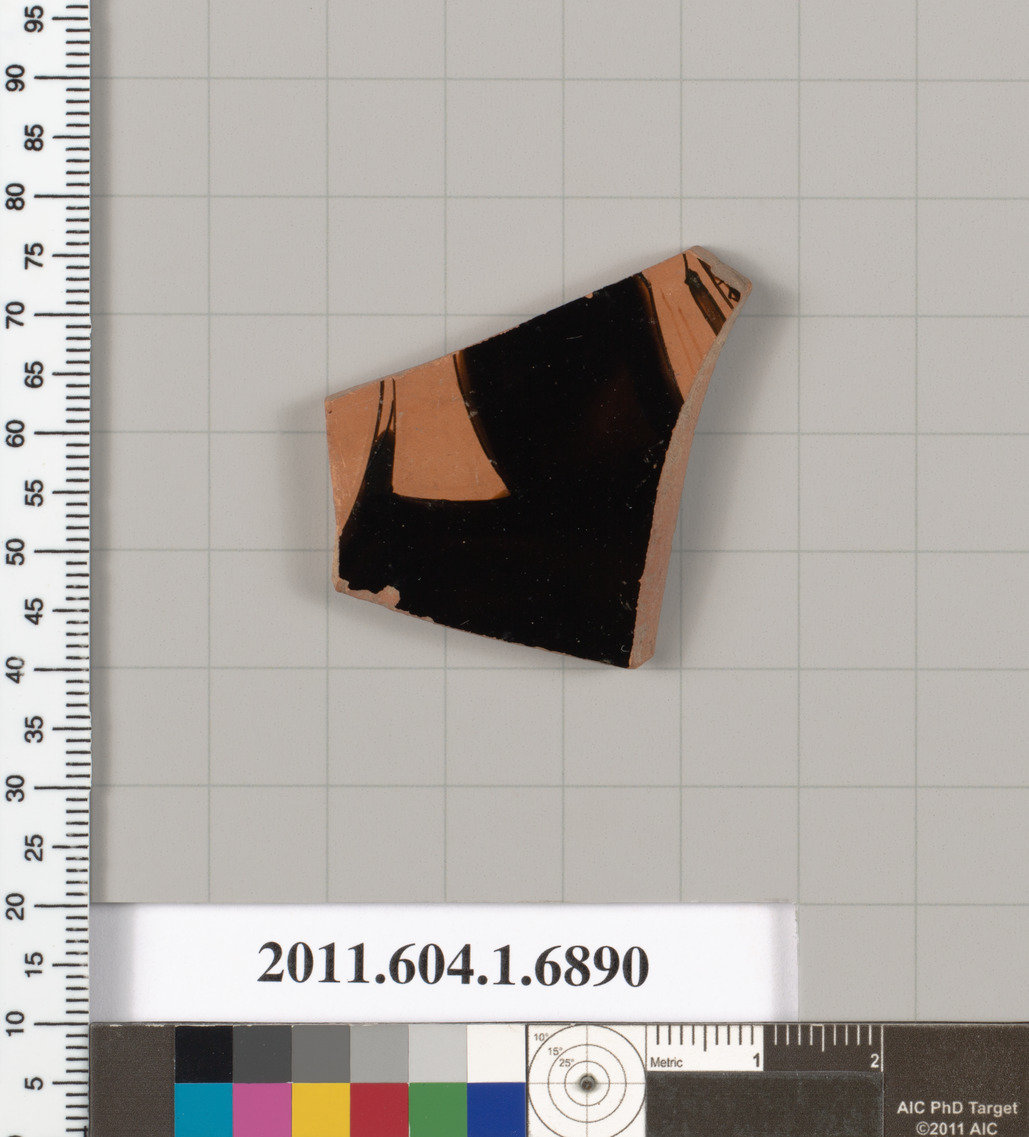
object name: kylix fragment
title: Terracotta fragment of a kylix (drinking cup)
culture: greek, attic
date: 490-470 BCE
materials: terracotta